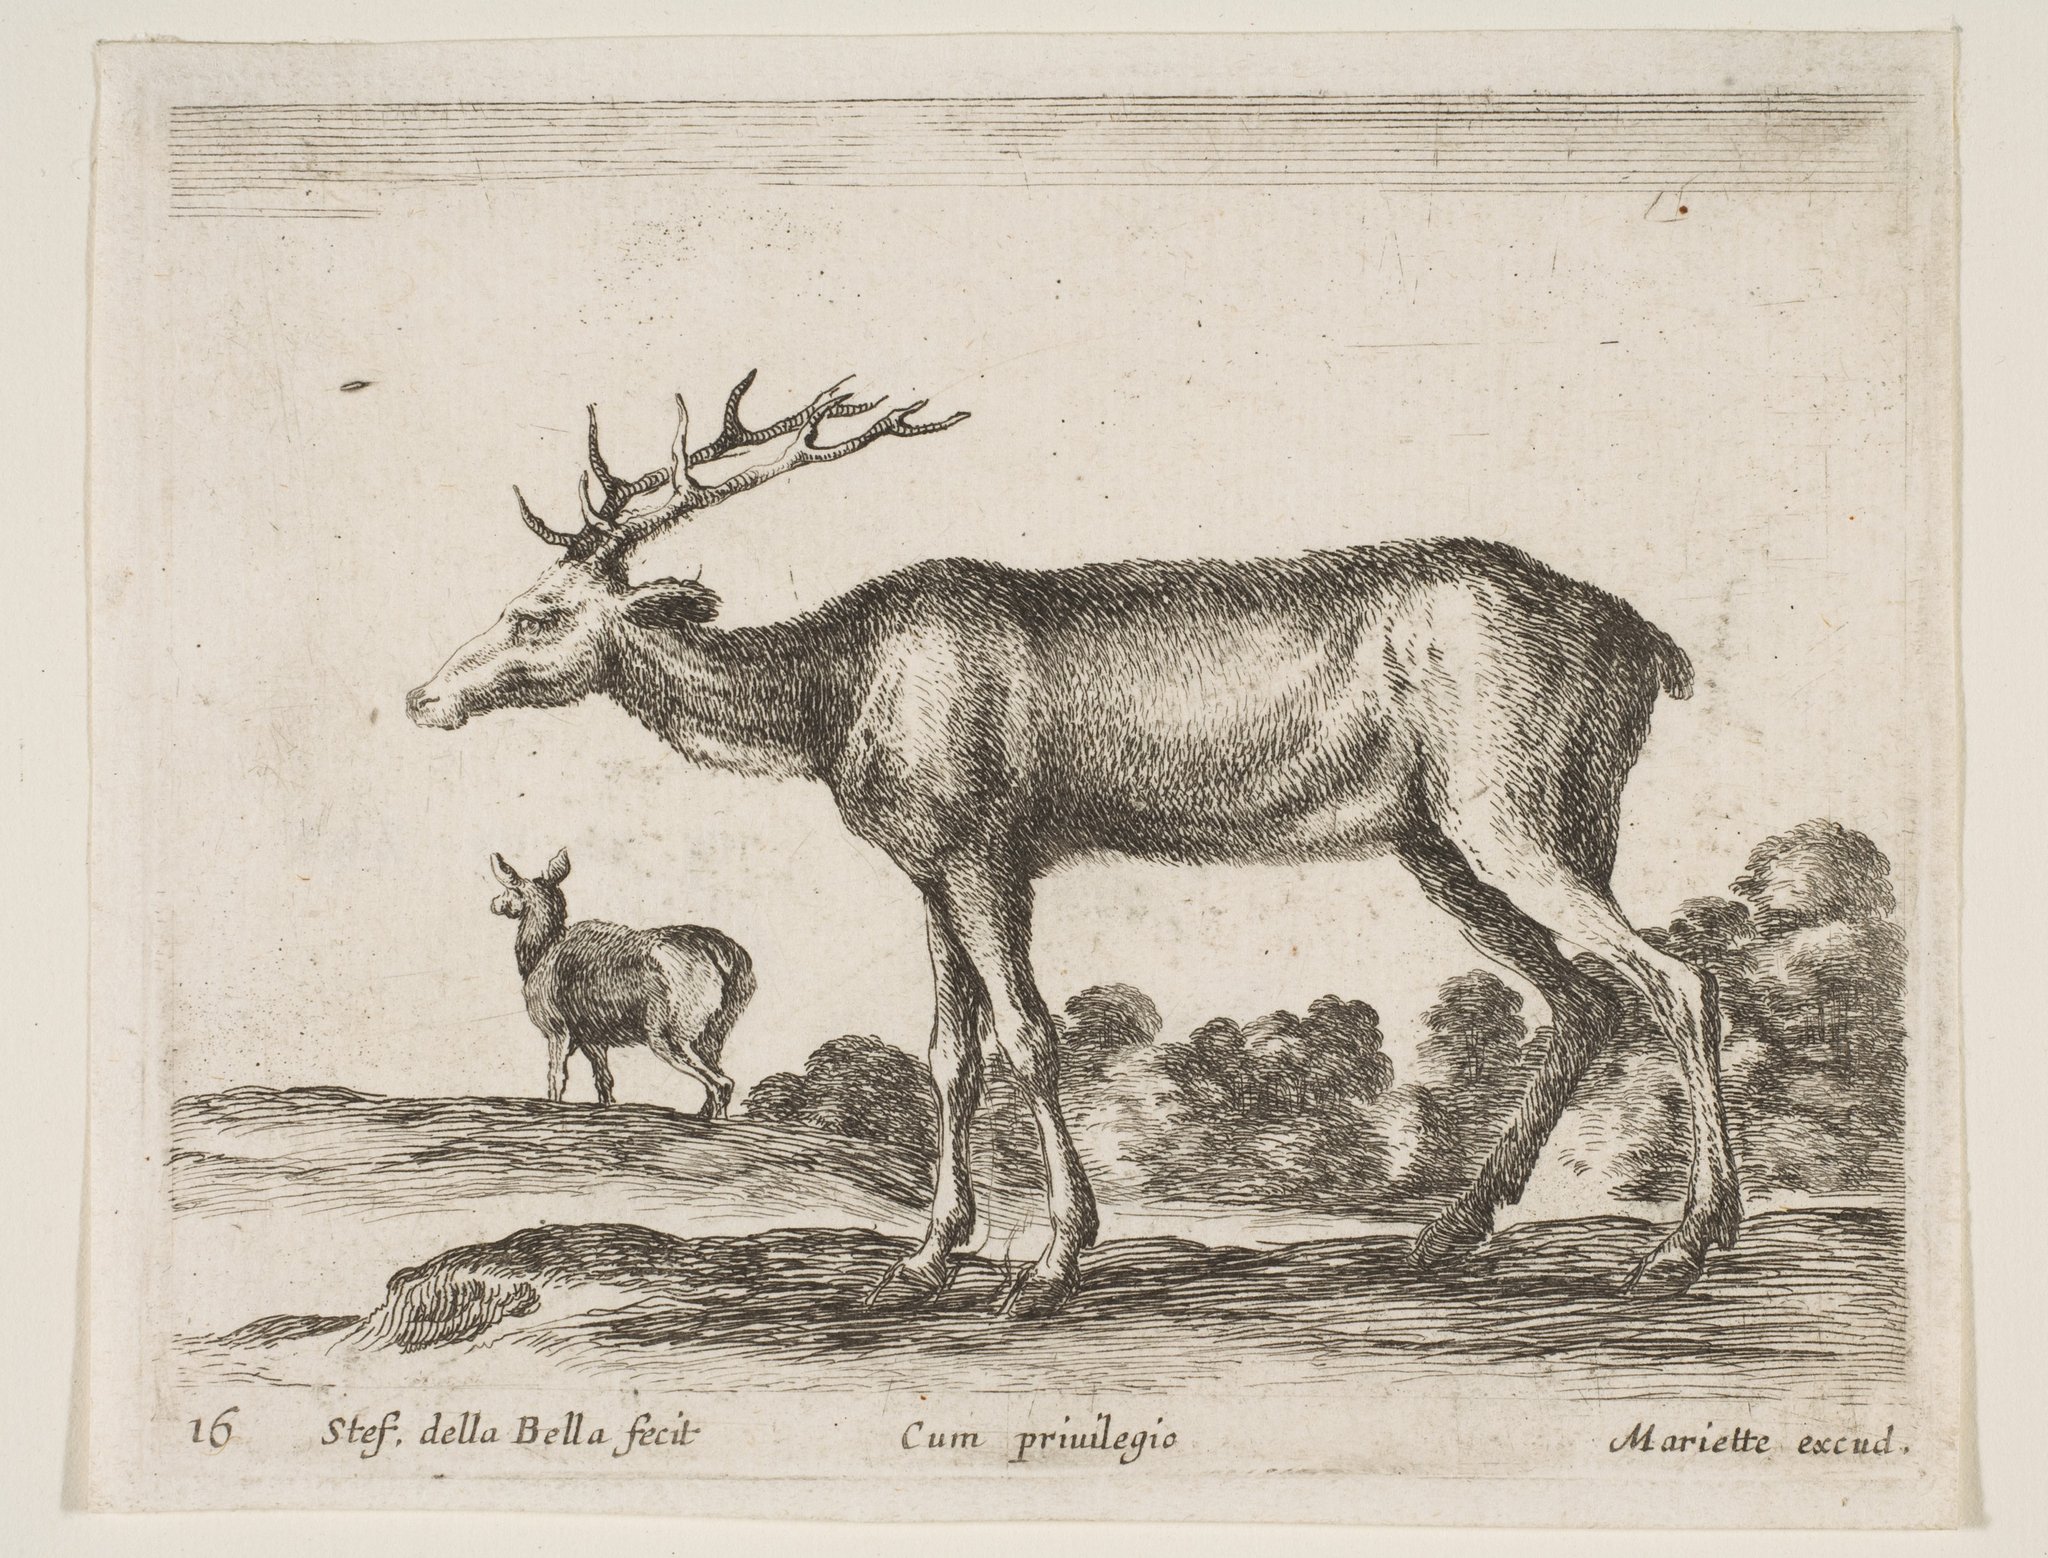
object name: print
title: Stag, plate 16 from "Various Animals" (Diversi Animali)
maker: stefano della bella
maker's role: artist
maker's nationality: italian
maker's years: 1610-1664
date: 1641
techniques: etching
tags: deer